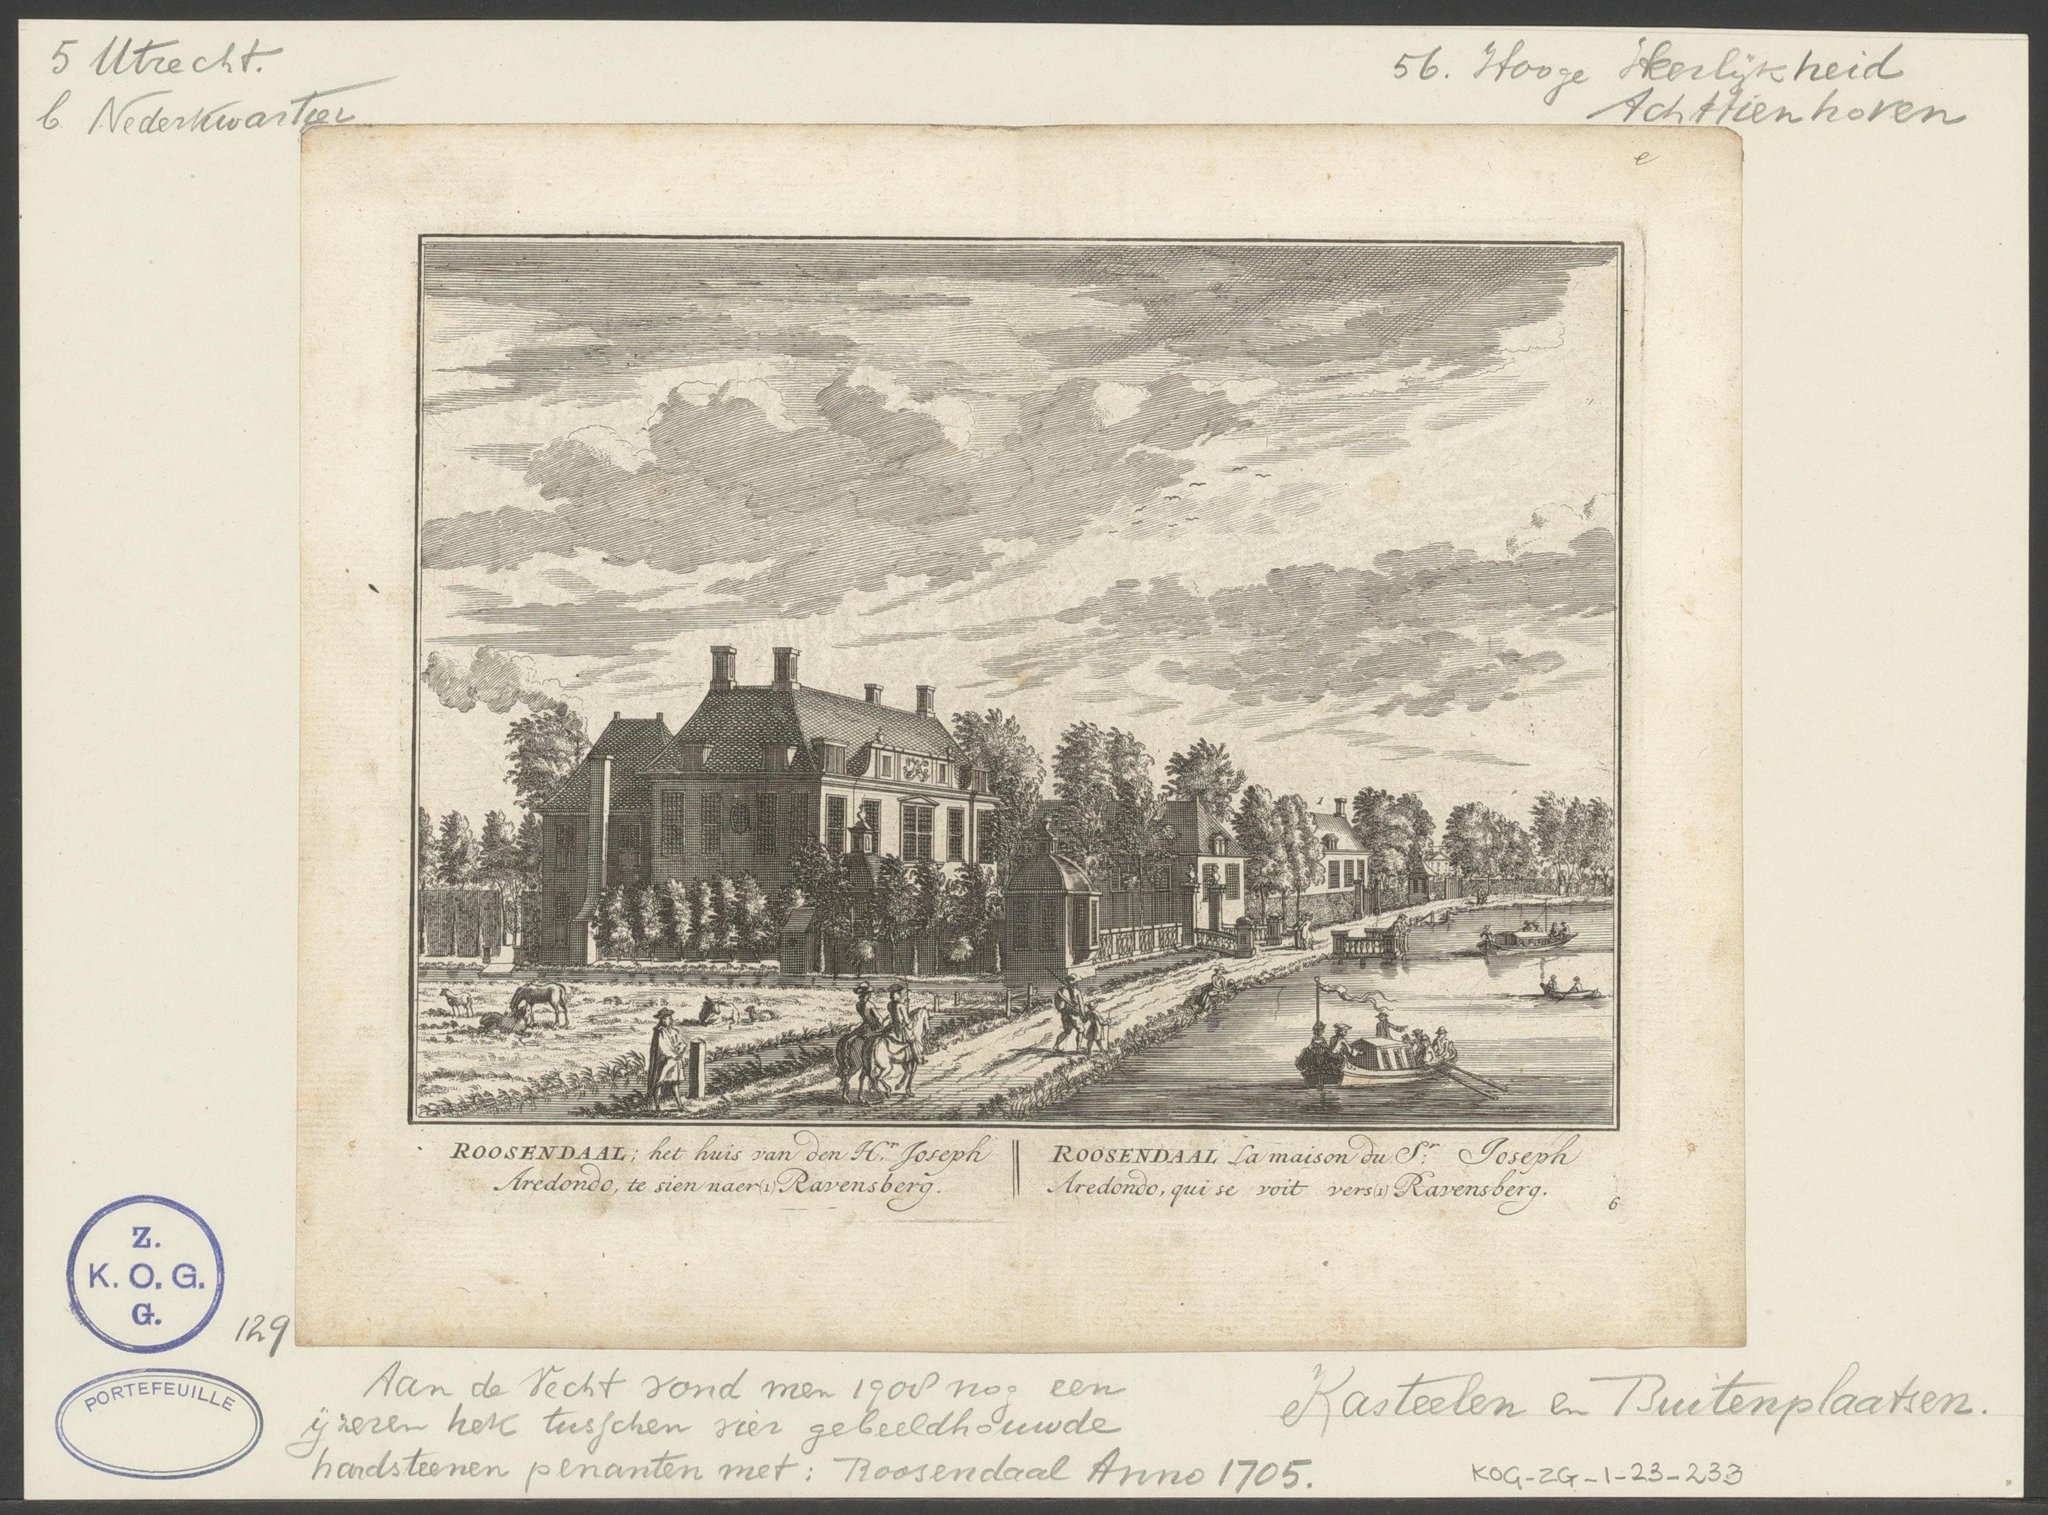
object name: print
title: Roosendaal; het huis van den Hr. Joseph Aredondo, te sien naer (1) Ravensberg / Roosendaal La maison du Sr. Joseph Aredondo, qui se voit vers (1) Ravensberg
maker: daniël stopendaal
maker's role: print maker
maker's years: 1672-1726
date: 1790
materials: paper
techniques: engraving, etching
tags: rural housing, e.g. country-house, villa, cottage, river (+ landscape with figures, staffage), vecht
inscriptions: stamp, collector's mark: Lugt 1641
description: Prent voor het eerst gebruikt in: Leth, Andries de. De zegepraalende Vecht, vertoonende verscheidene gesichten van lustplaatsen, heeren huysen en dorpen, beginnende van Uitrecht en met Muyden besluytende (...). Amsterdam: Weduwe Nicolaus Visscher, 1719. Prent mogelijk uit: Brouërius van Nidek, Matthaeus. De Vechtstroom, van Utrecht tot Muiden (...). Amsterdam: H. Gartman, W. Vermandel en J.W. Smit, 1790.